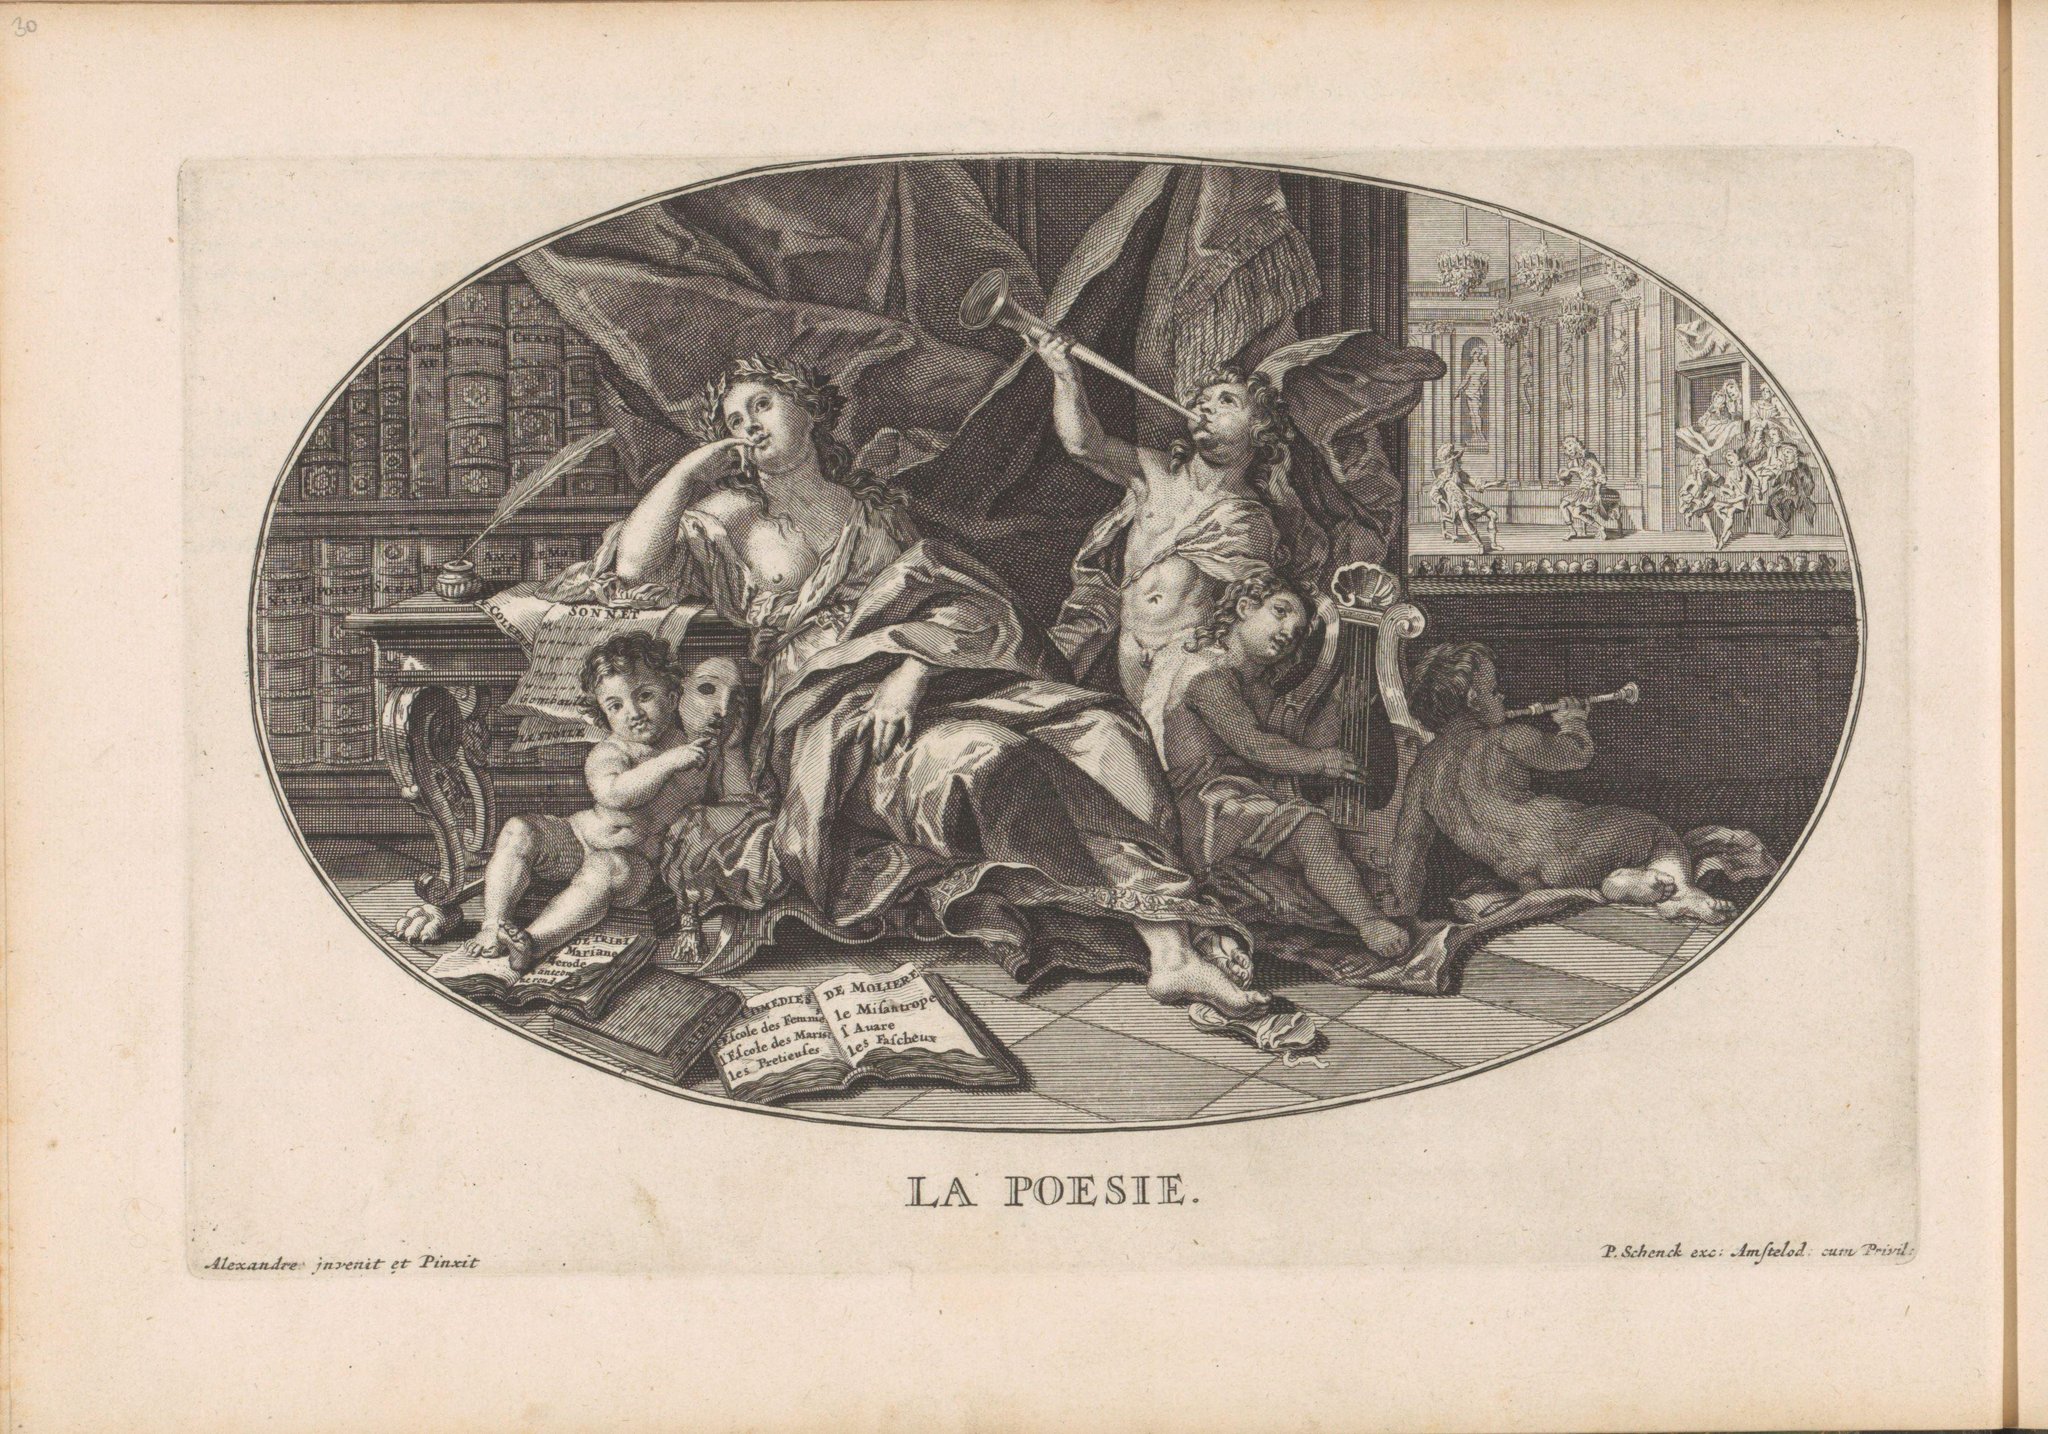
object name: print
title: Poëzie of Dichtkunst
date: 1693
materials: paper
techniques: engraving, etching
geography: amsterdam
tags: symbolic representations, allegories and emblems ~ poetry; 'poesia' (ripa), (decorated) ceiling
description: Plafondstuk met de gepersonifieerde Dichtkunst, leunend tegen een schrijftafel met lauwerkrans op het hoofd. Rondom haar putti met muziekinstrumenten en een masker. Links een boekenkast. Op de achtergrond rechts een theater waar het toneelstuk Cinna wordt opgevoerd. Prent maakt deel uit van een album.